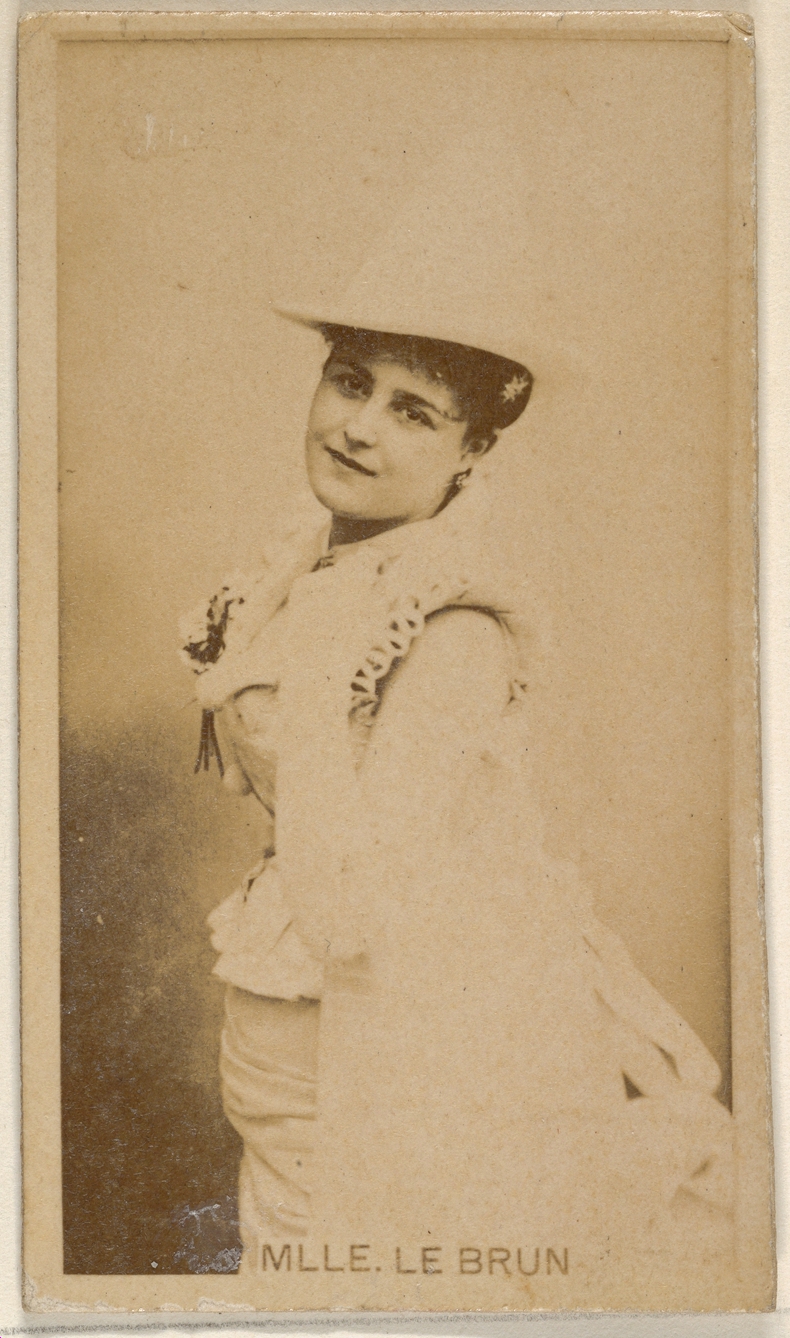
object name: photograph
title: Mlle. Le Brun, from the Actors and Actresses series (N45, Type 8) for Virginia Brights Cigarettes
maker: allen & ginter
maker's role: publisher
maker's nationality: american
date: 1888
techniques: albumen silver print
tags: portraits,women,actresses